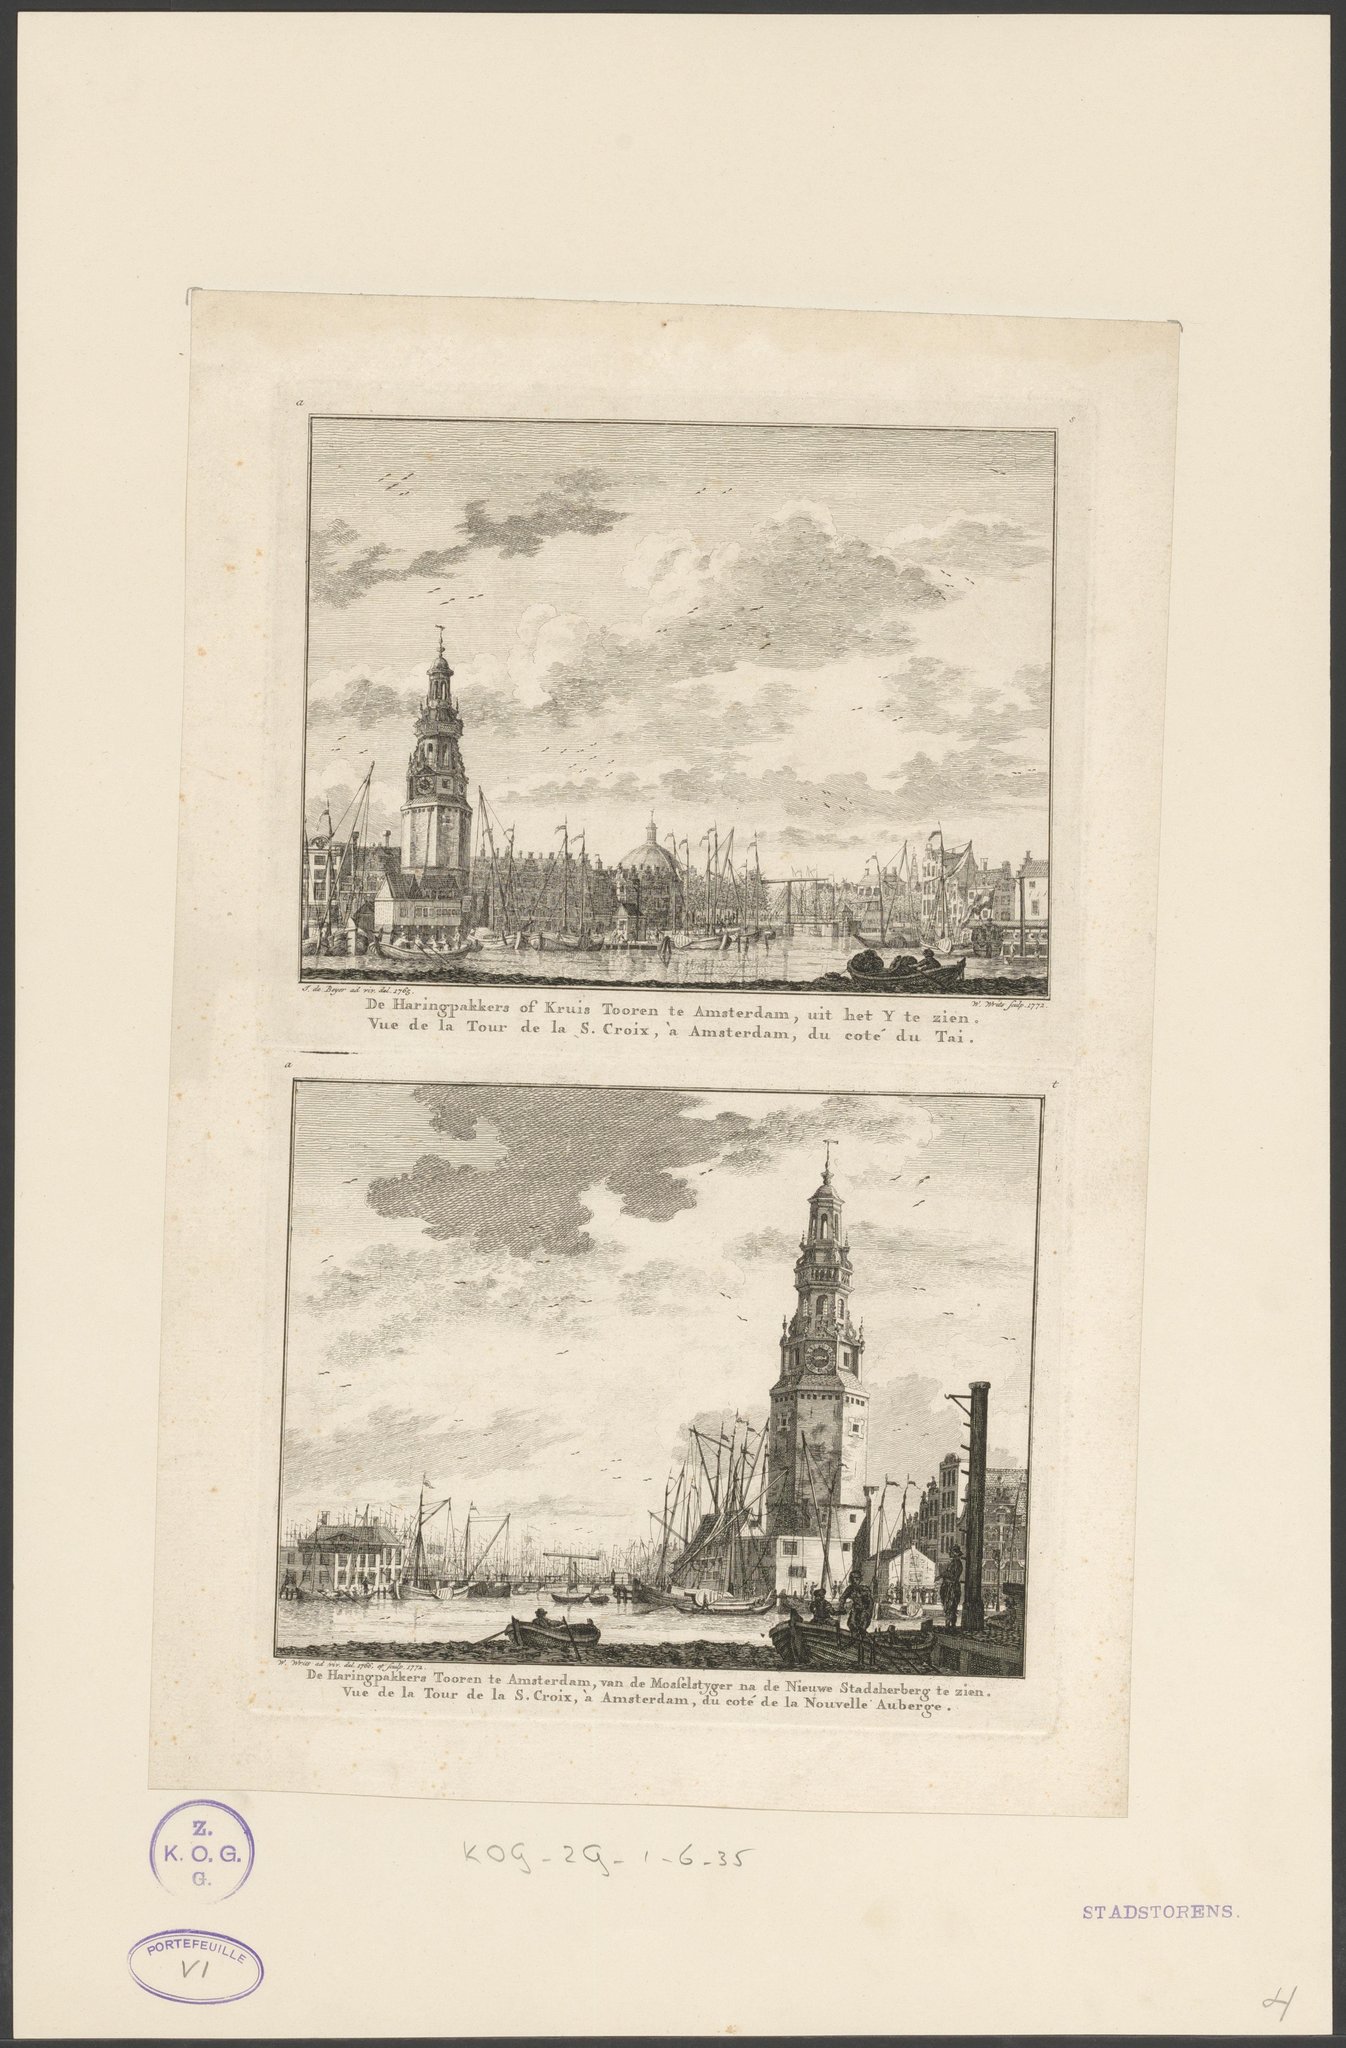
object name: print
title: De Haringpakkers of Kruis Tooren te Amsterdam, uit het Y te zien / De Haringpakkers Tooren te Amsterdam, van de Mosselstyger na de Nieuwe Stadsherberg te zien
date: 1772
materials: paper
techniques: engraving, etching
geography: amsterdam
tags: harbour, towers ~ fortified city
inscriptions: stamp, stamp, collector's mark: Lugt 1641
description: Bovenaan de bovenste plaat gemerkt: a s. Bovenaan de onderste plaat gemerkt: a t. Onderwerpsrubrieken binnen de Atlas Zeden en Gewoonten: Krijgswezen, Stadstorens.